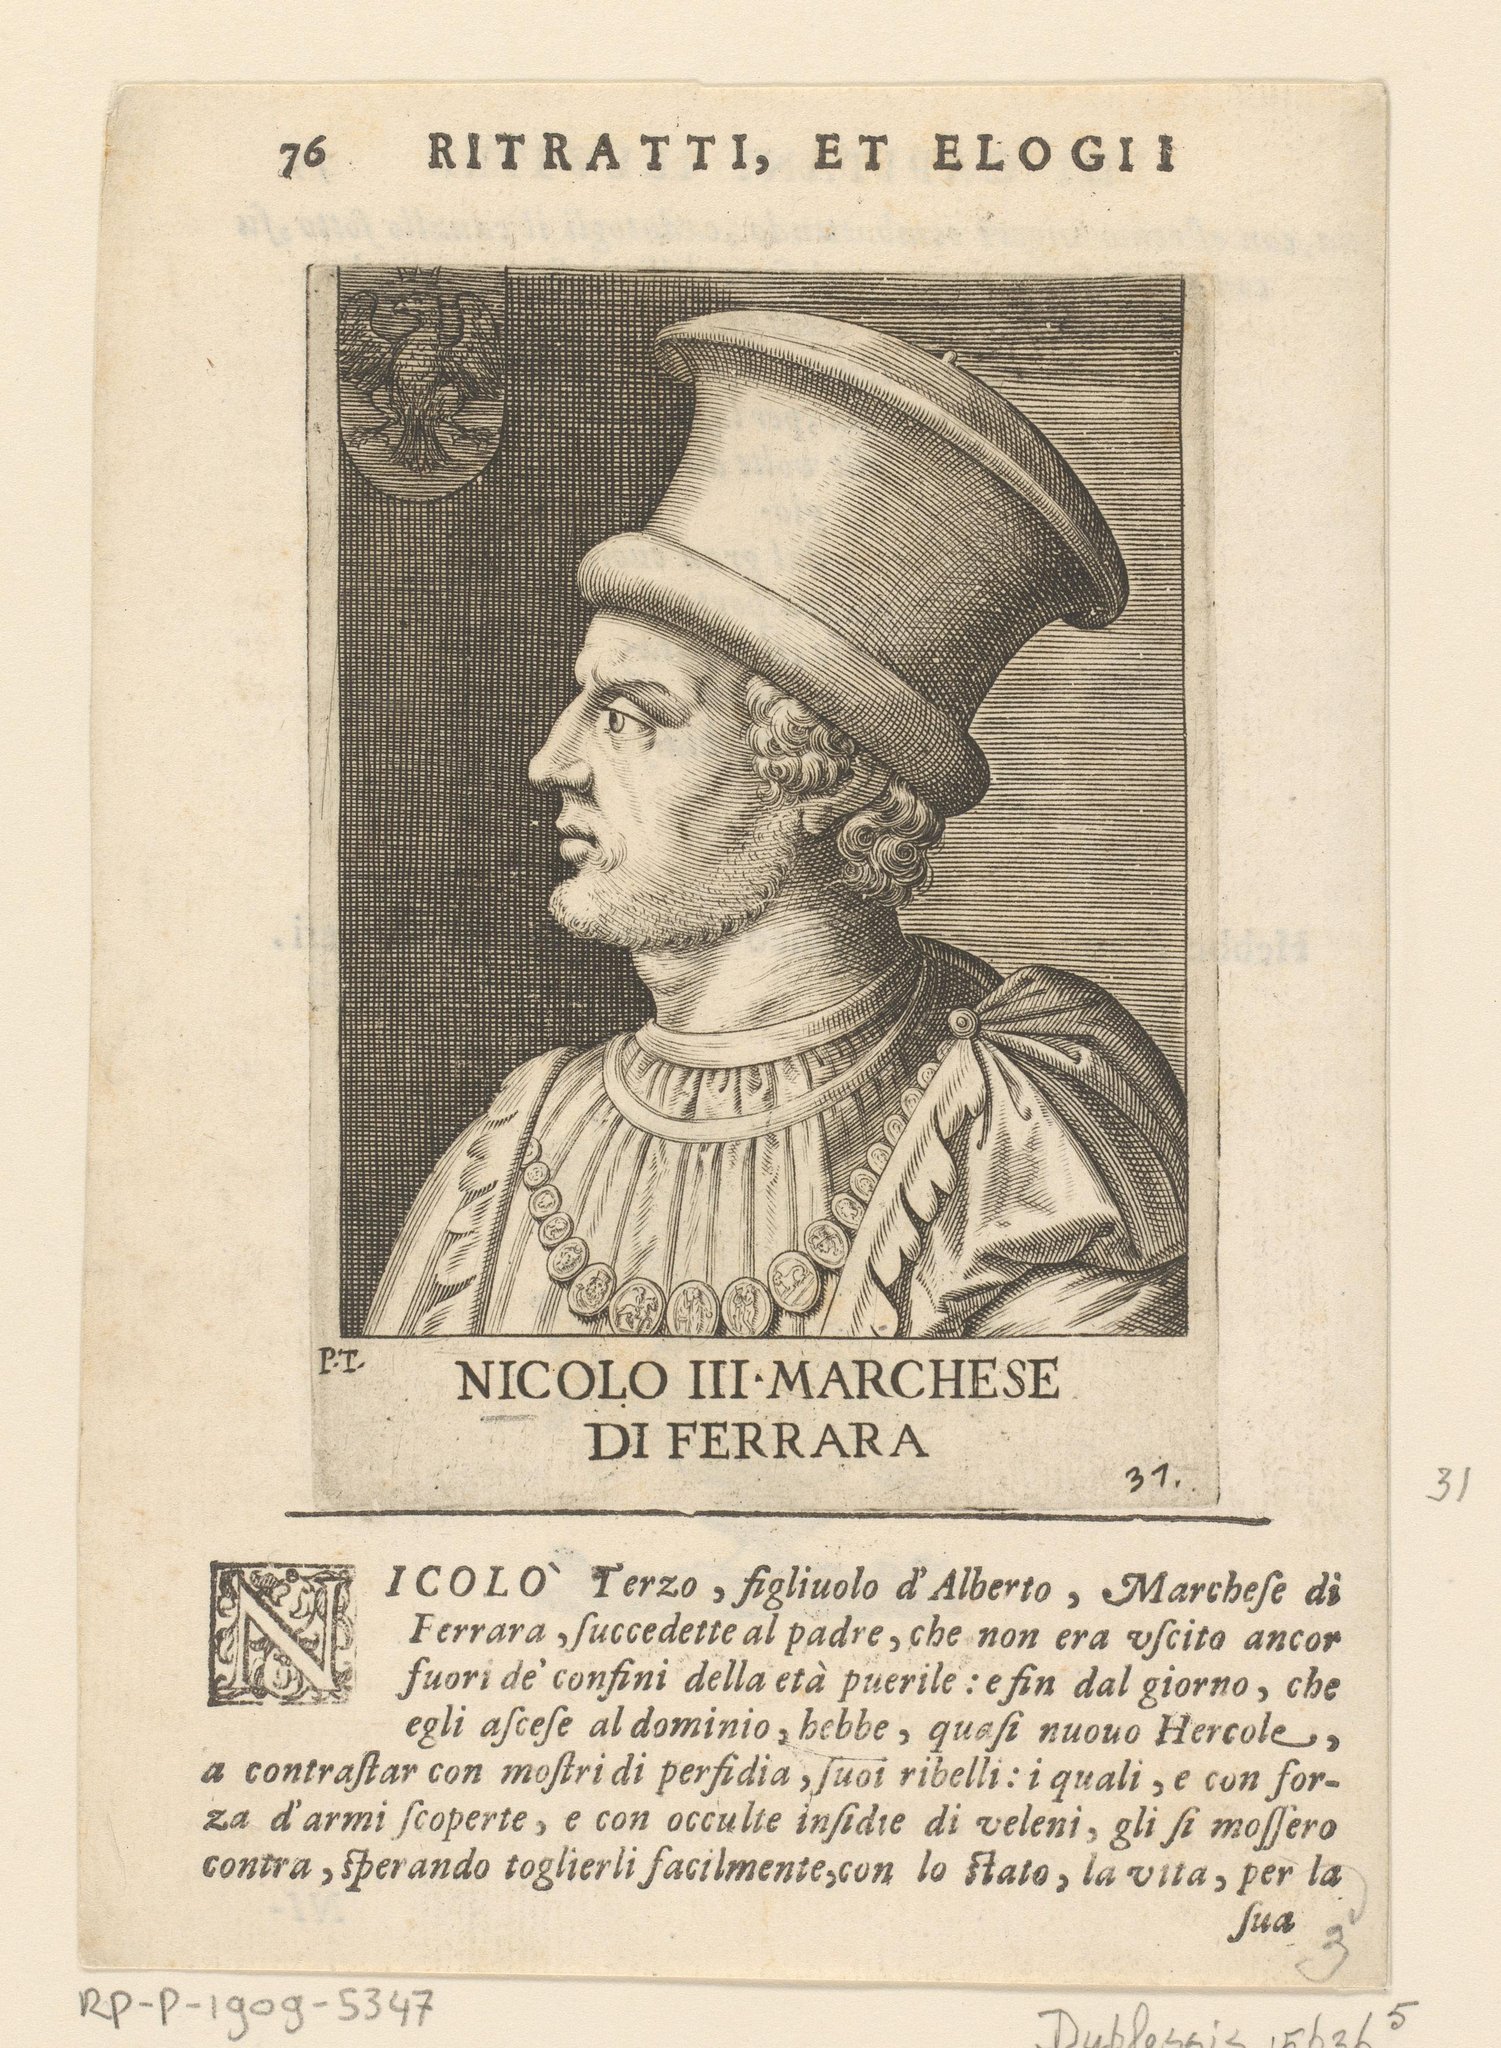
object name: book illustration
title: Nicolo III. marchese di Ferrara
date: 1635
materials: paper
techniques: engraving, letterpress printing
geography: rome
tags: ranks in the army, historical persons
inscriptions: collector's mark: Lugt 2228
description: Prent uit: Ritratti et elogii di capitani Illustri. Rome: Pompilio Totti en Andrea Fei, 1635, p. 76. Eerdere staat van prent in ieder geval ook gebruikt in: Ritratti di cento capitani illustri con li lor Fatti in guerra (…), Rome: Domenico Gigliotti, 1596. Latere staat van prent in ieder geval ook gebruikt in: Ritratti et elogii di capitani Illustri. Che ne'secoli moderni hanno gloriosamente guerreggiato. Rome: Filippo de'Rossi en Vitale Mascardi, 1646.